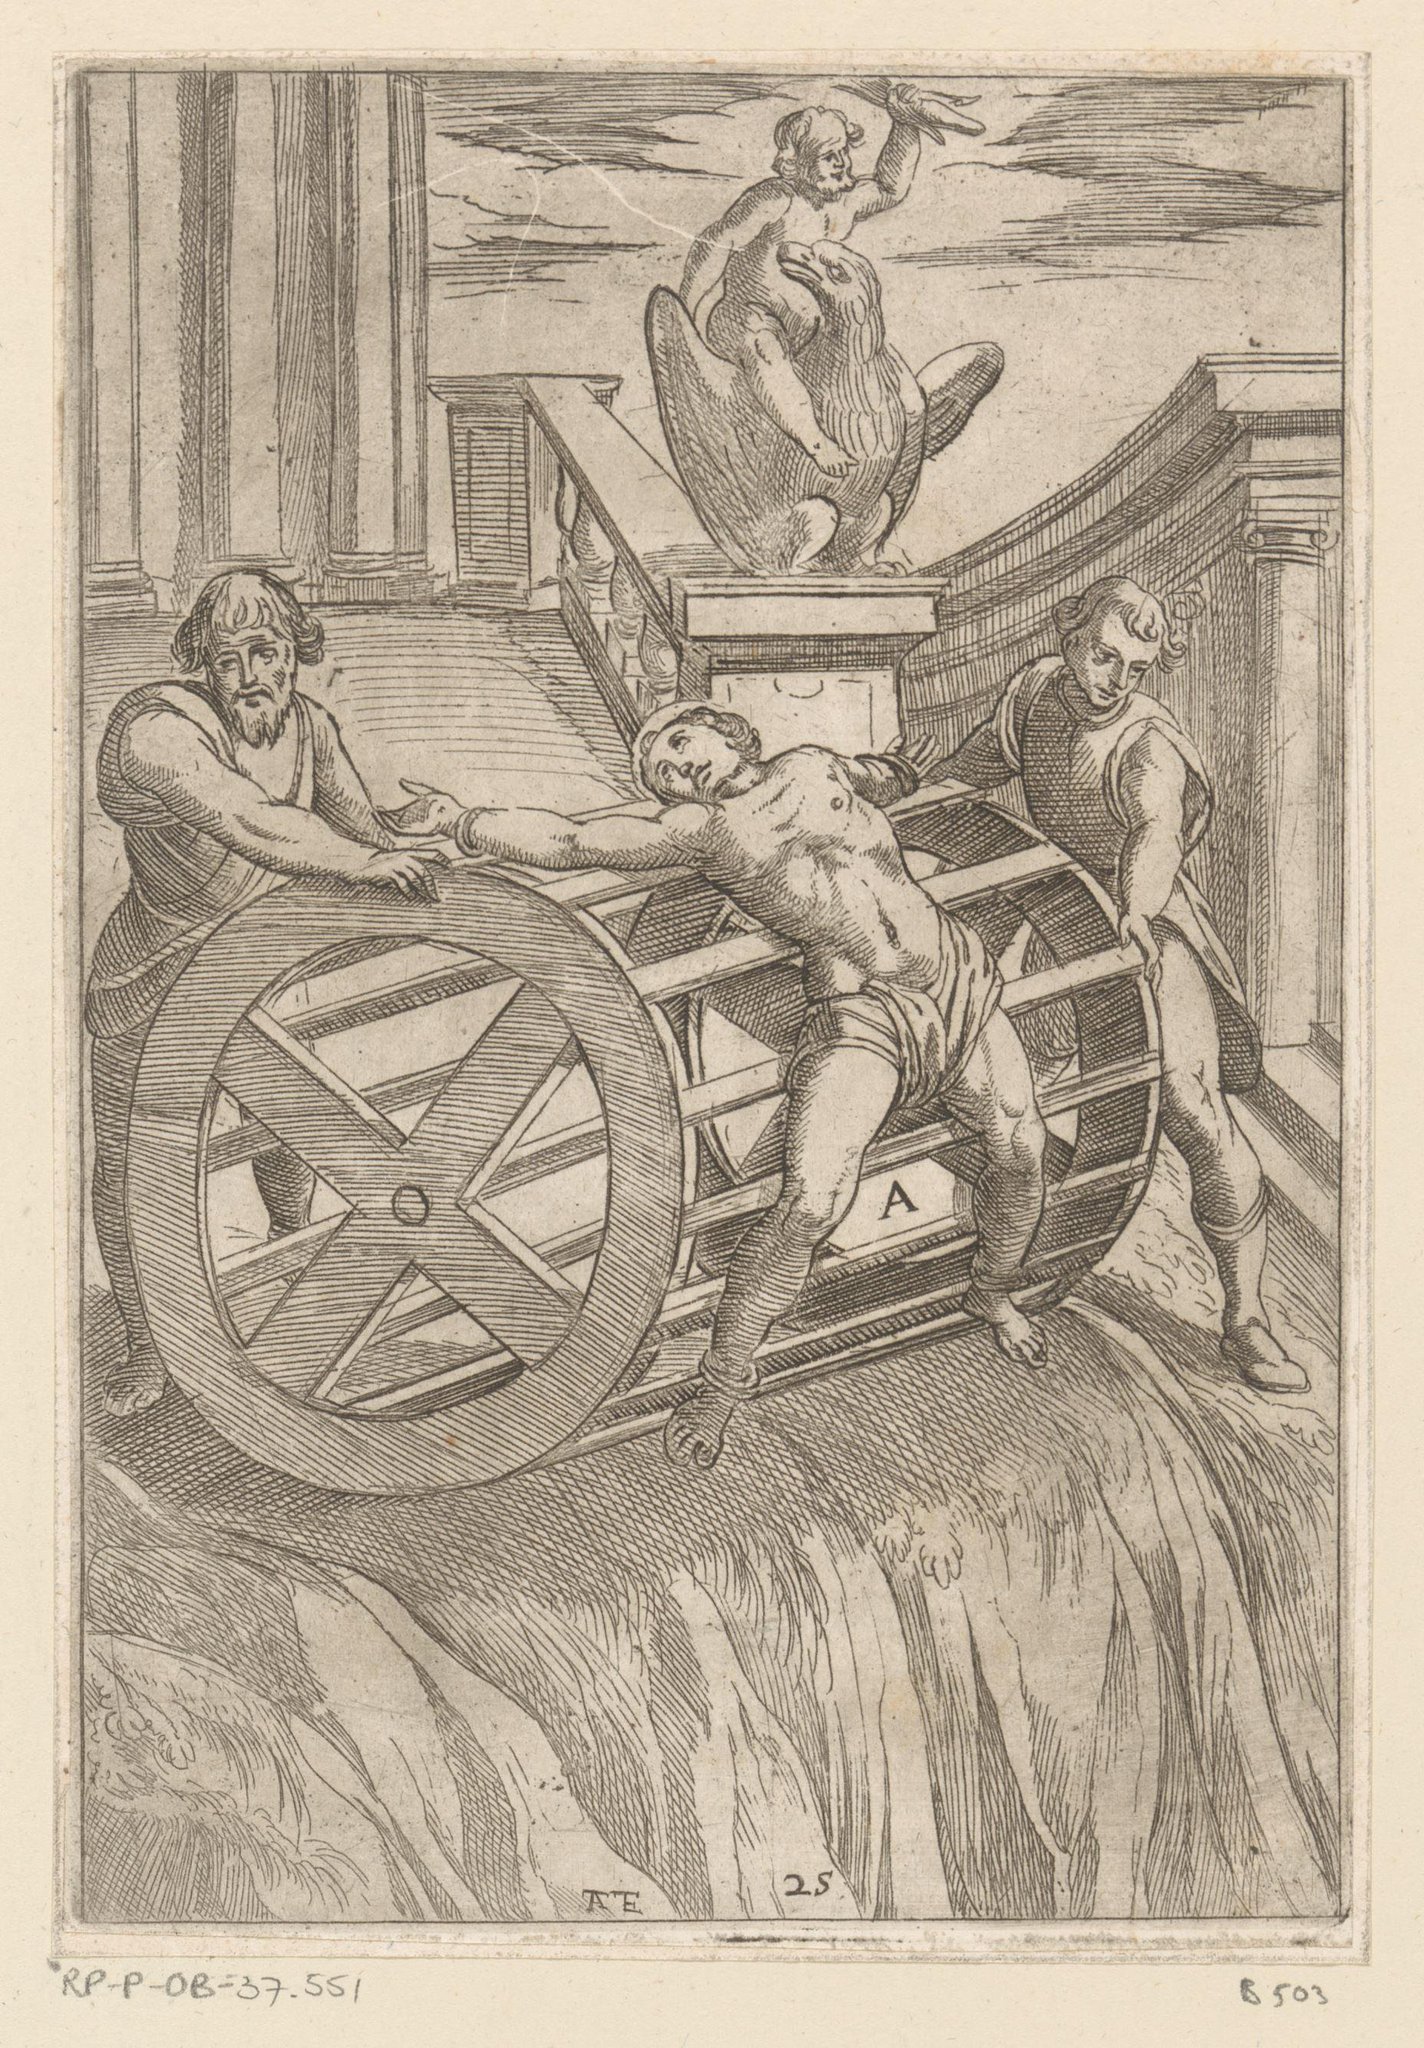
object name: print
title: Foltering op vat met staven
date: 1565-1630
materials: paper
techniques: etching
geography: italy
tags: violent death ~ maltreatment, torture, torture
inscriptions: collector's mark: Lugt 240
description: Deze prent maakt deel uit van een reeks van 47 prenten (+ titelprent) met voorstellingen van martelmethoden. Deze prenten zijn in een andere editie gebruikt als illustraties voor Antonio Gallonio's 'Trattato degli Instrumenti di Martirio e delle Varie Maniere di Martoriare Usate dai Gentili contro Christiani' (Rome, Ascanio en Girolamo Dongangeli, 1591).